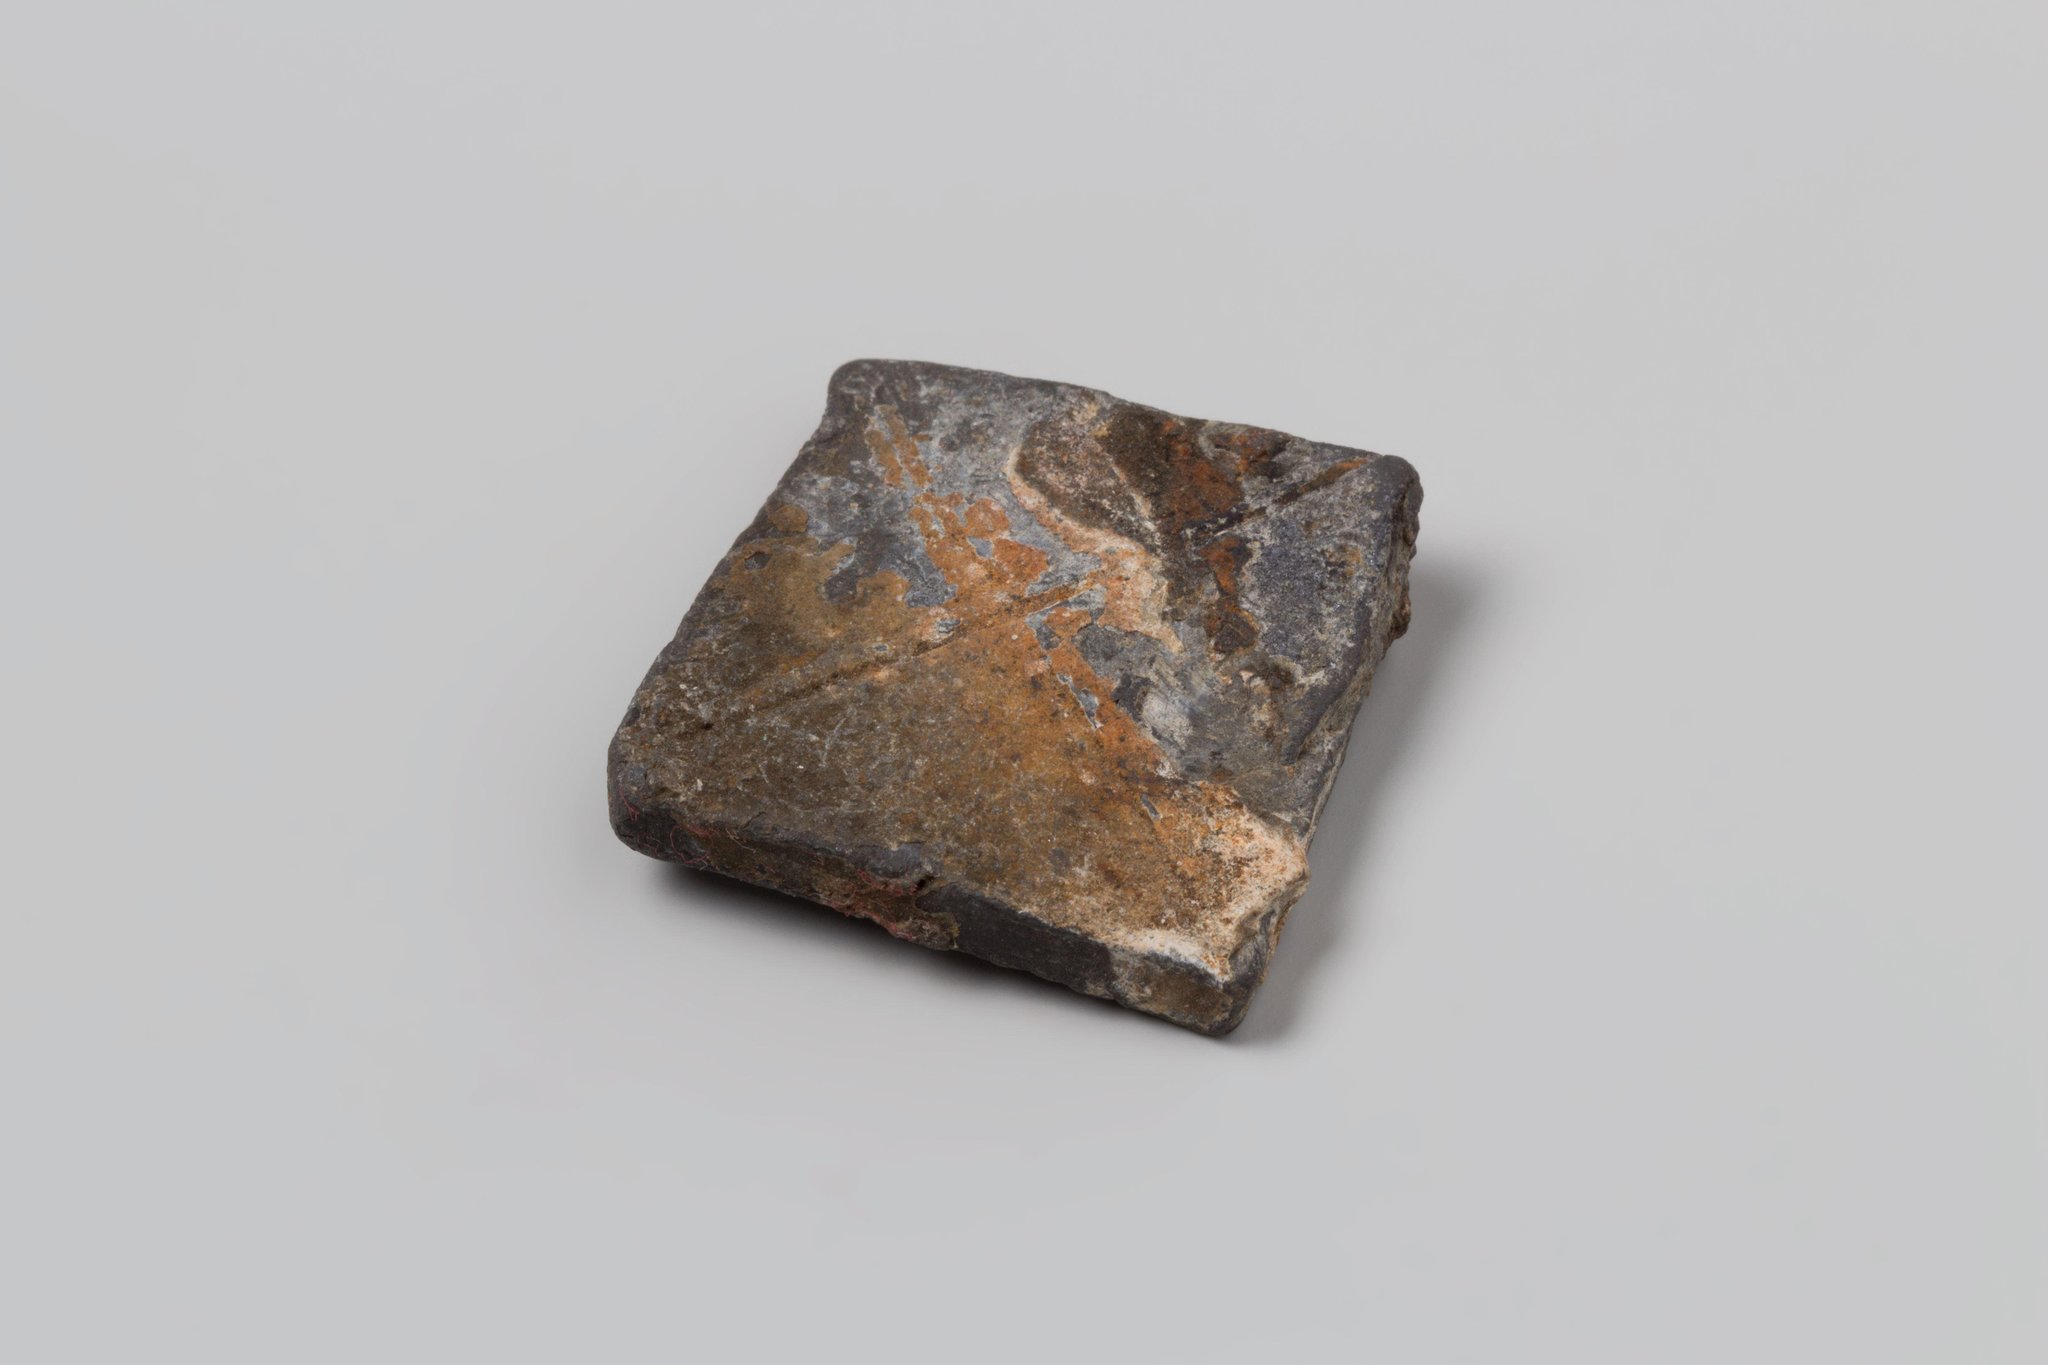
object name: gaming counter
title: Speelpenning uit het wrak van de Oost-Indiëvaarder Hollandia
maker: Anonymous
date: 1700-1743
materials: lead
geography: netherlands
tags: verenigde oostindische compagnie, hollandia (schip), annet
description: Rectangular, square, flat, engraved diagonal cross on one side, game token.